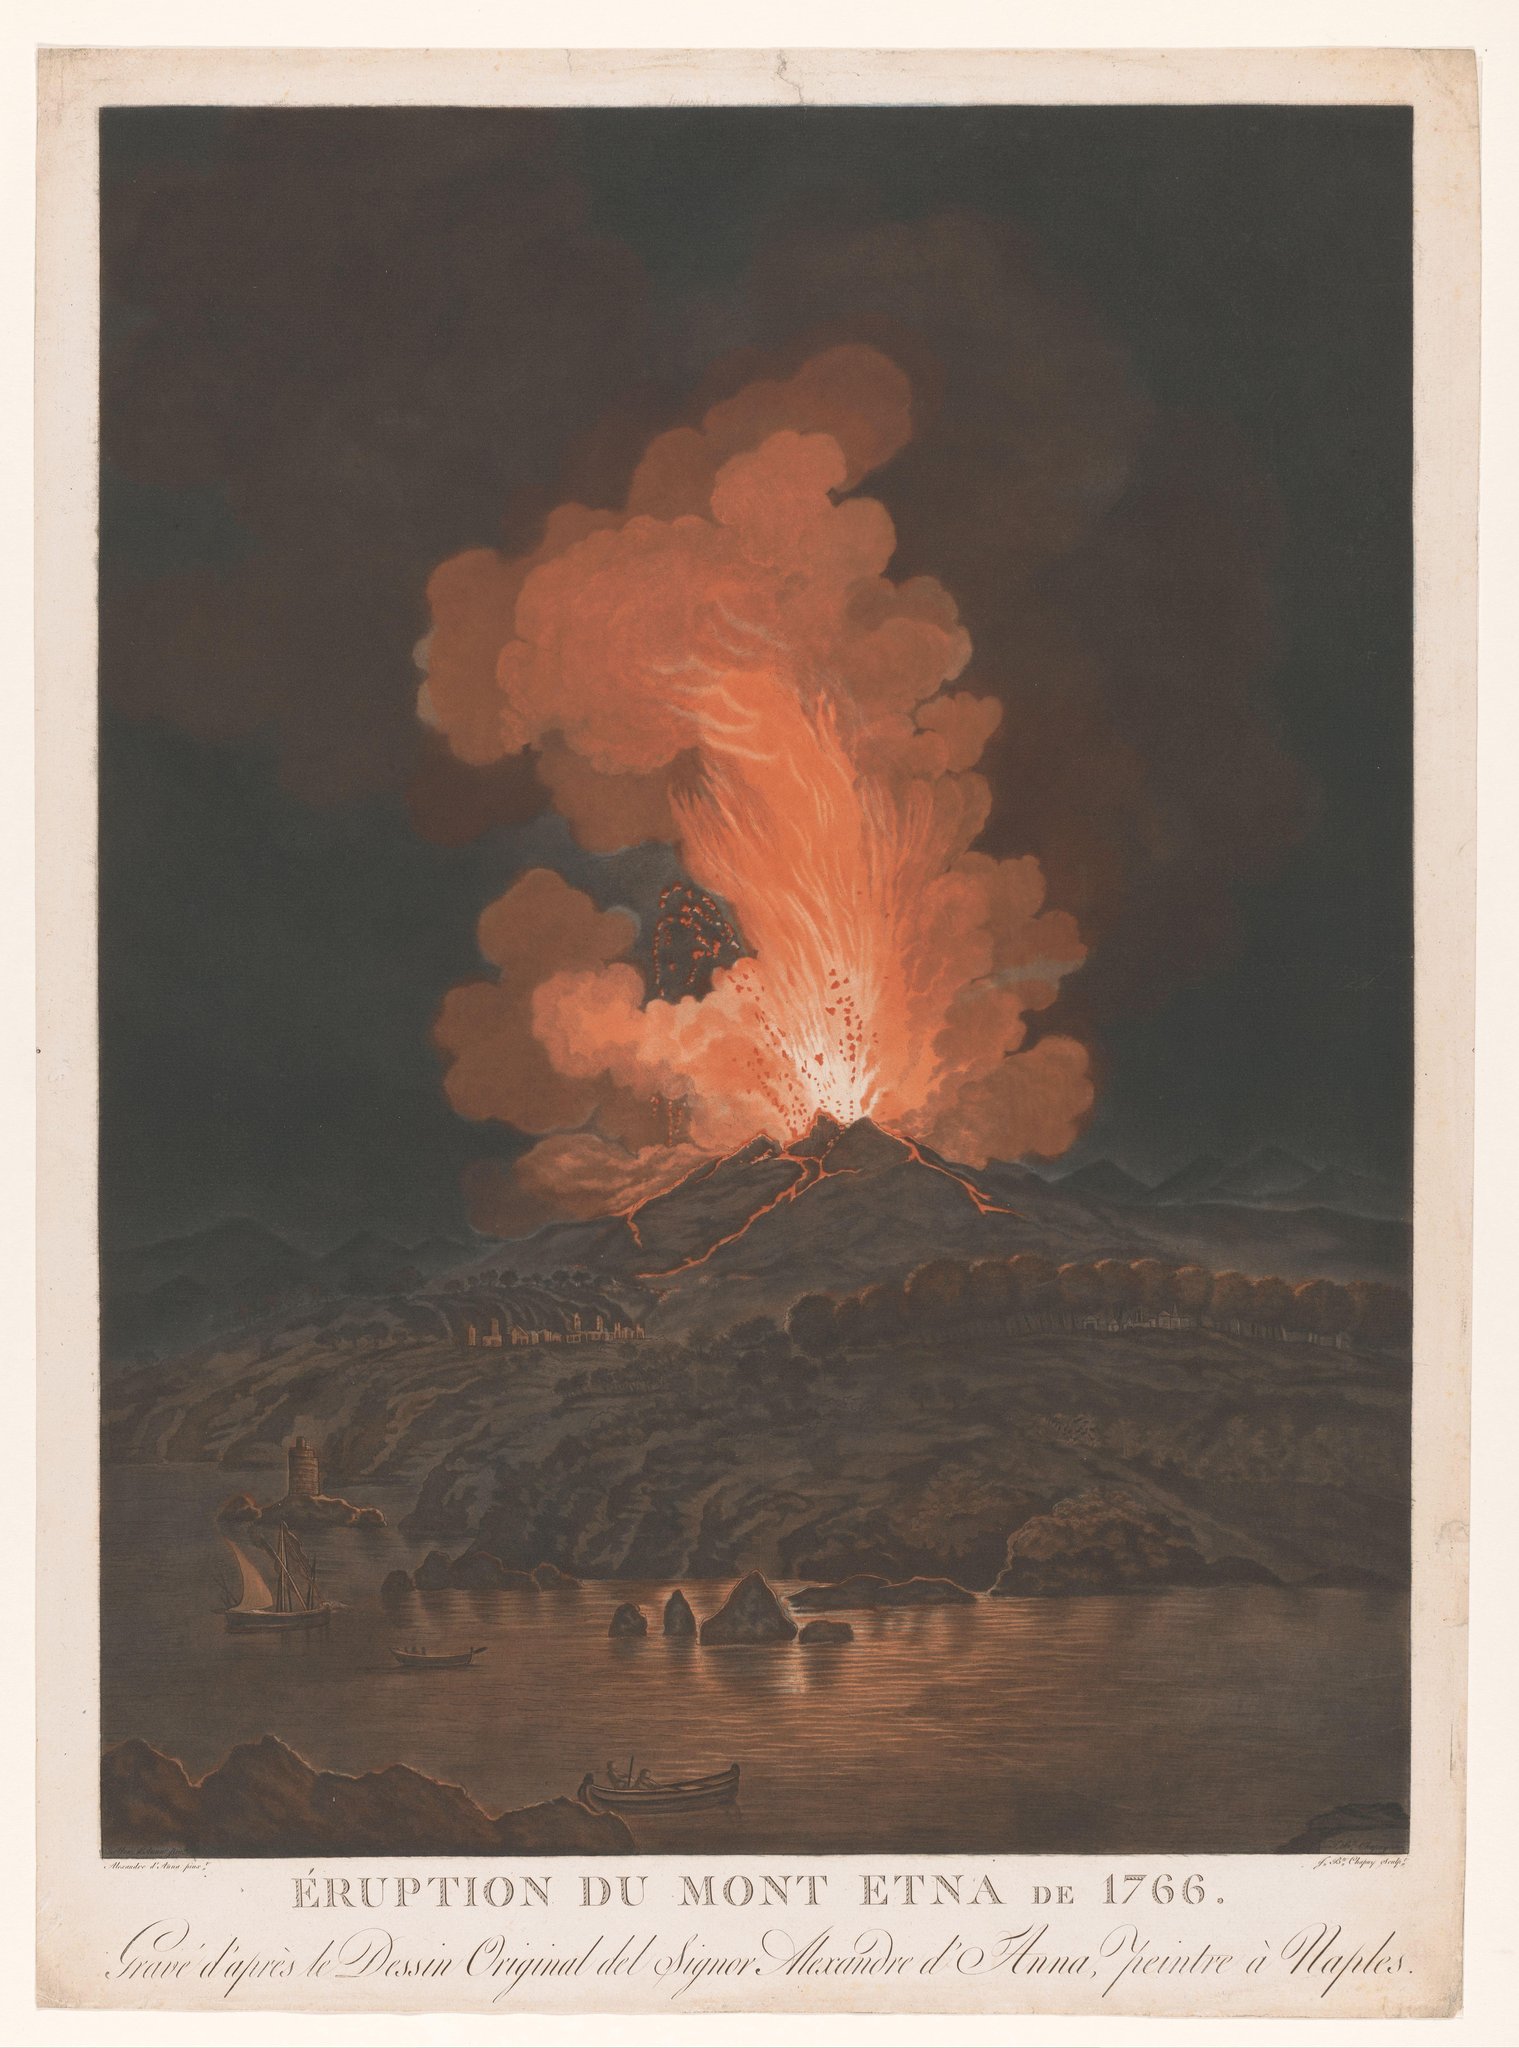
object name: print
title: Éruption du mont Etna de 1766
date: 1770-1802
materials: paper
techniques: color mezzotint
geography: naples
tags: eruption (of volcano)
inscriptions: collector's mark: Lugt 2228